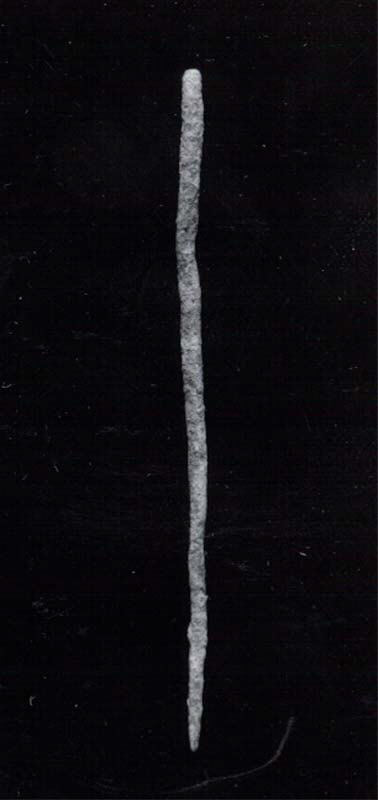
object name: pin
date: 2400 BCE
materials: copper alloy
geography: anatolia (?)